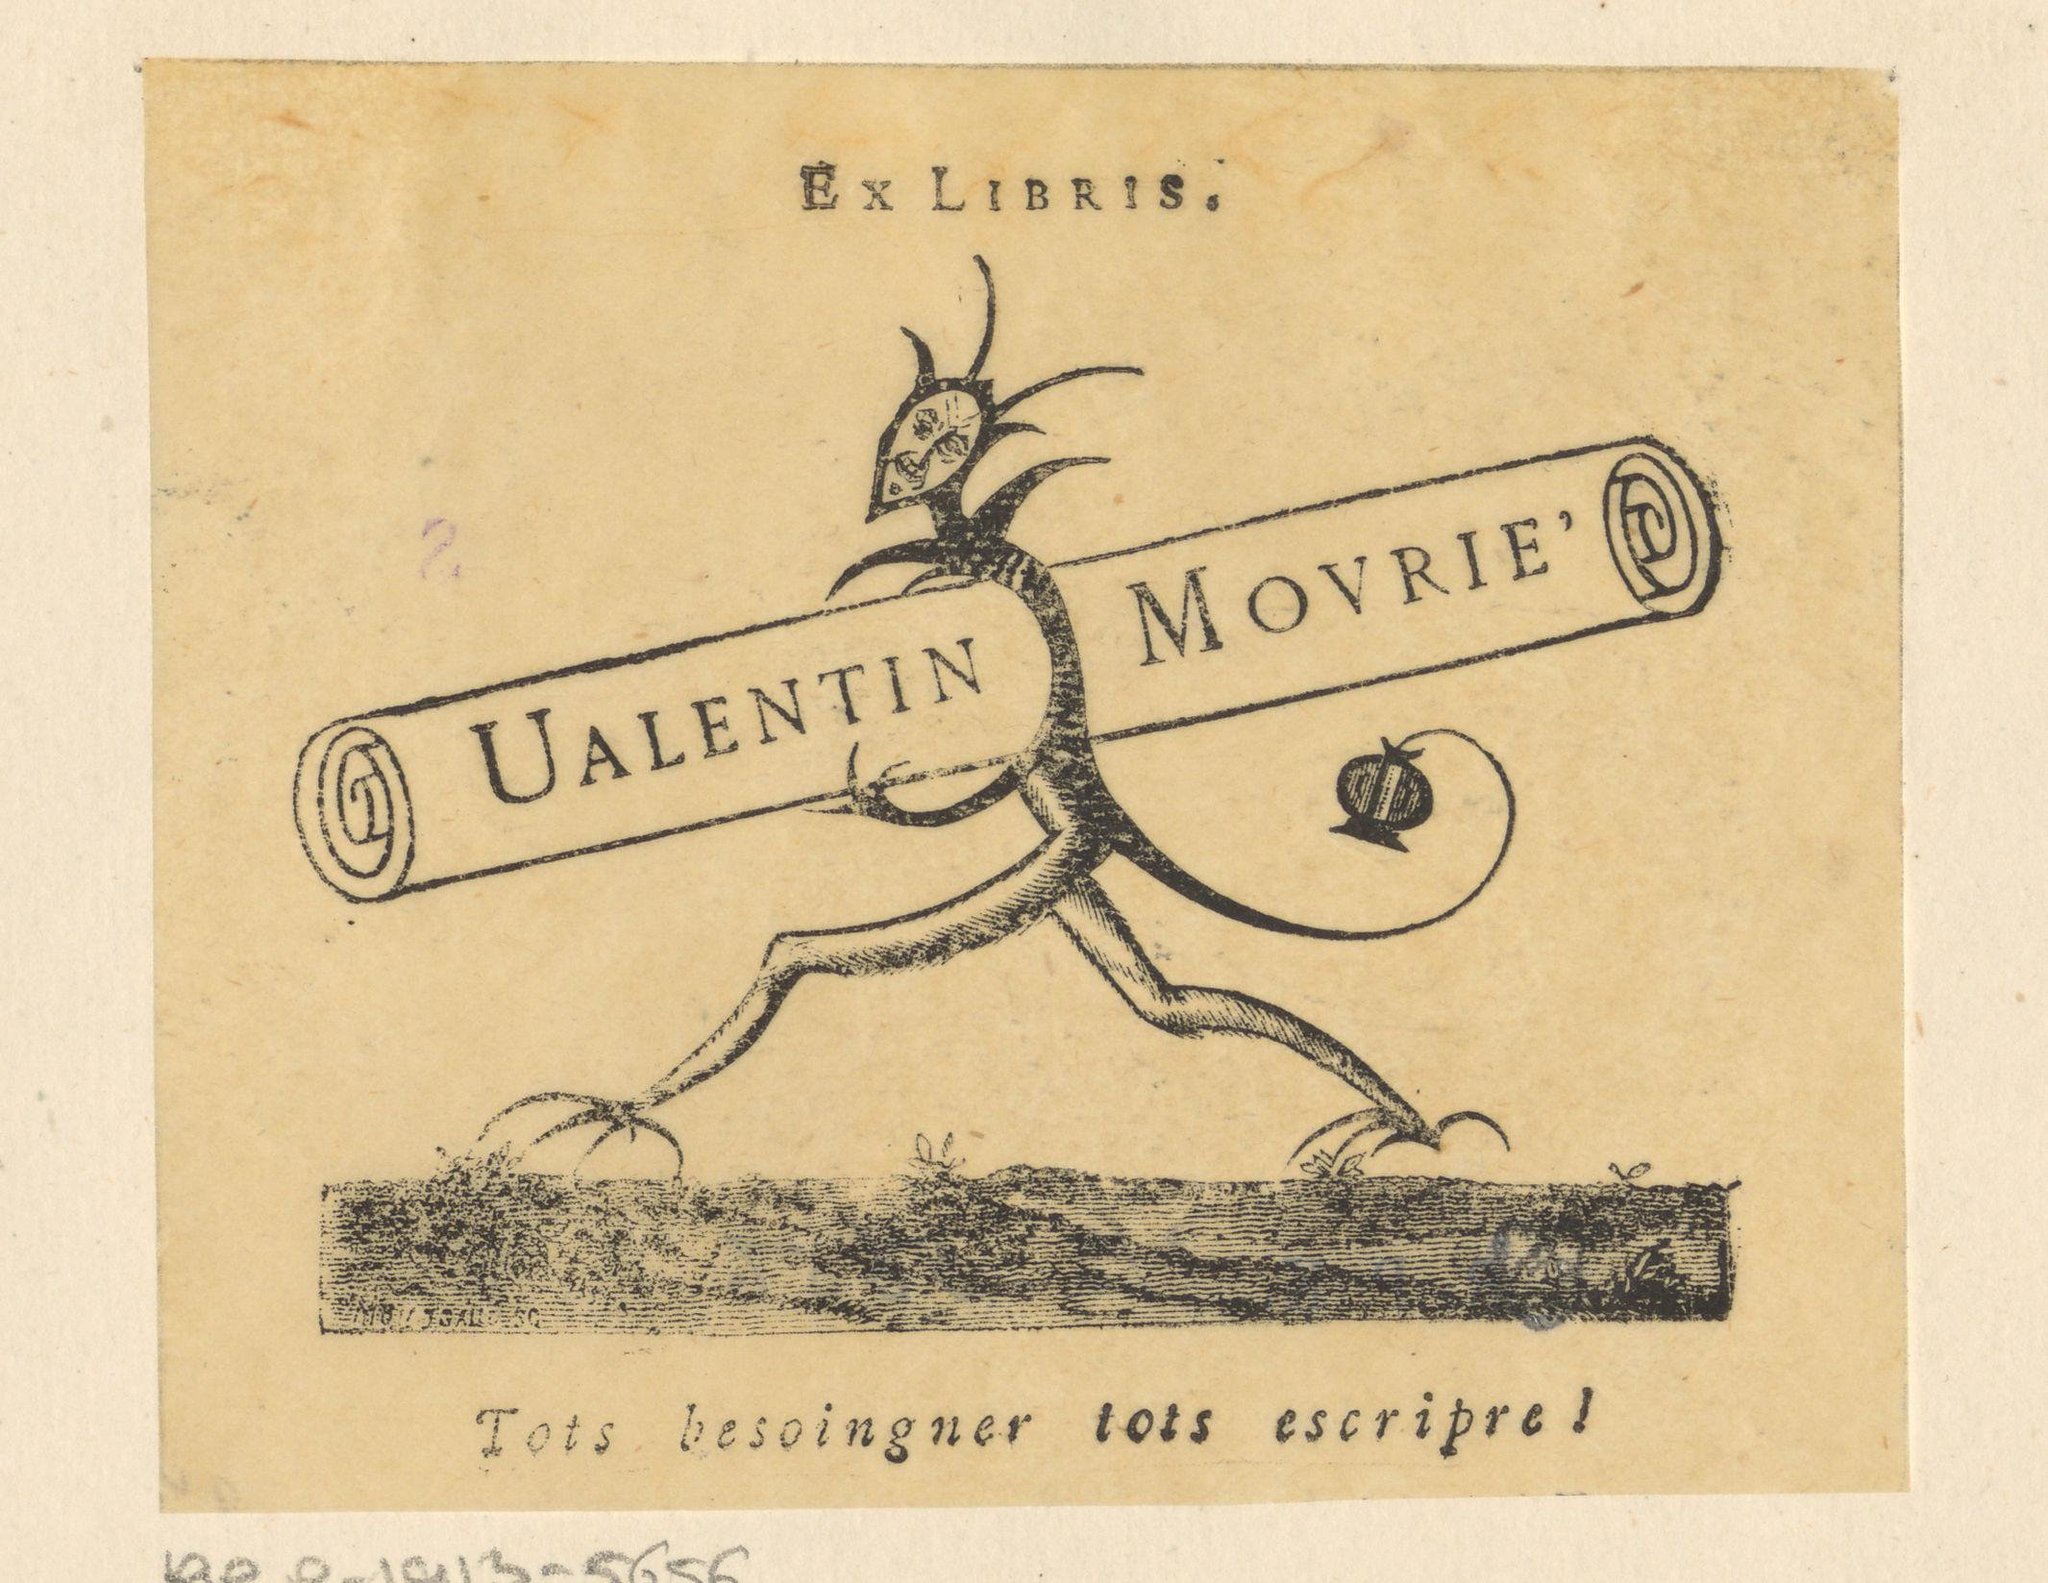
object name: bookplate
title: Ex libris Ualentin Movrie'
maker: Anonymous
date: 1850-1913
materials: paper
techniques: letterpress printing, relief print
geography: france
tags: devil(s) and demons, scroll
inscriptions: collector's mark: Lugt 2233, collector's mark: ‘S’, collector's mark: Lugt 2760